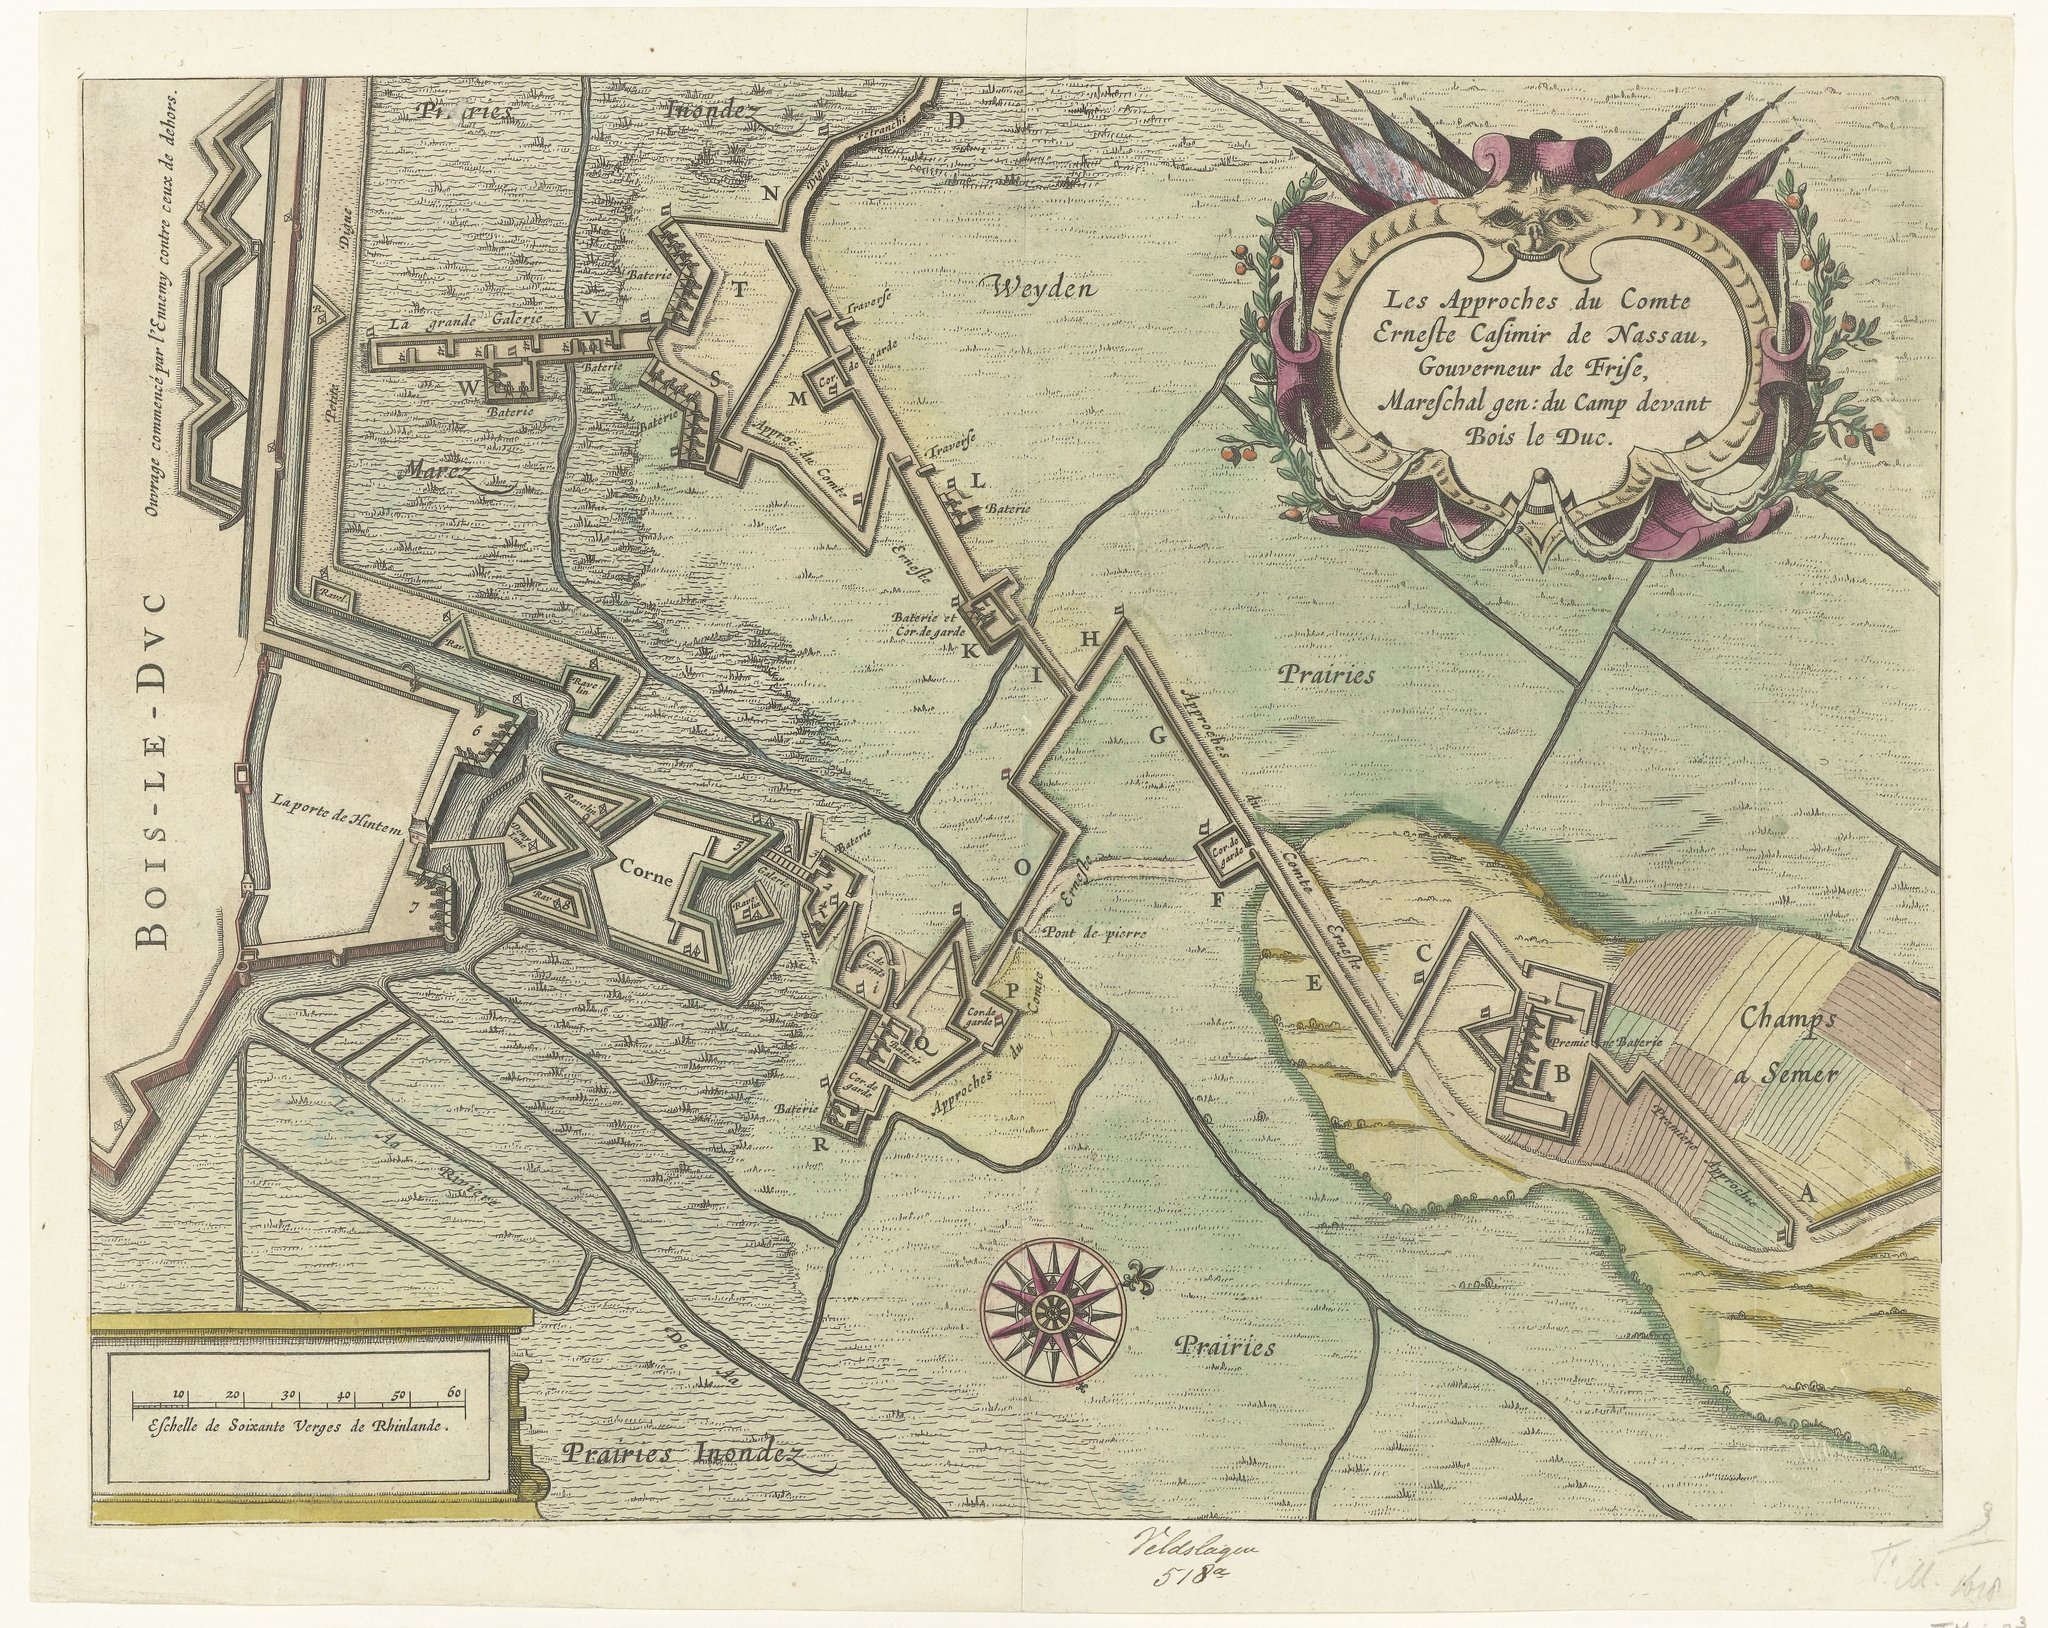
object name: print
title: Zeven deelkaarten betreffende het beleg van Den Bosch in 1629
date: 1629-1630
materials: paper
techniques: etching, hand coloring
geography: northern netherlands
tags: delft, frederick henry (prince of orange), ernst casimir graaf van nassau-dietz, maps of separate countries or regions, fortifications, military engineering, den bosch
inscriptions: collector's mark, inscription: ‘Veldslagen 518a’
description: Loopgraven van het Staatse leger onder graaf Ernst Casimir tot aan de stad. Onderdeel van het beleg van Den Bosch door het Staatse leger onder Frederik Hendrik, van 1 mei tot 17 september 1629. Opschriften in de voorstelling in het Frans en Nederlands. Behoort waarschijnlijk bij de grote kaart van het beleg.